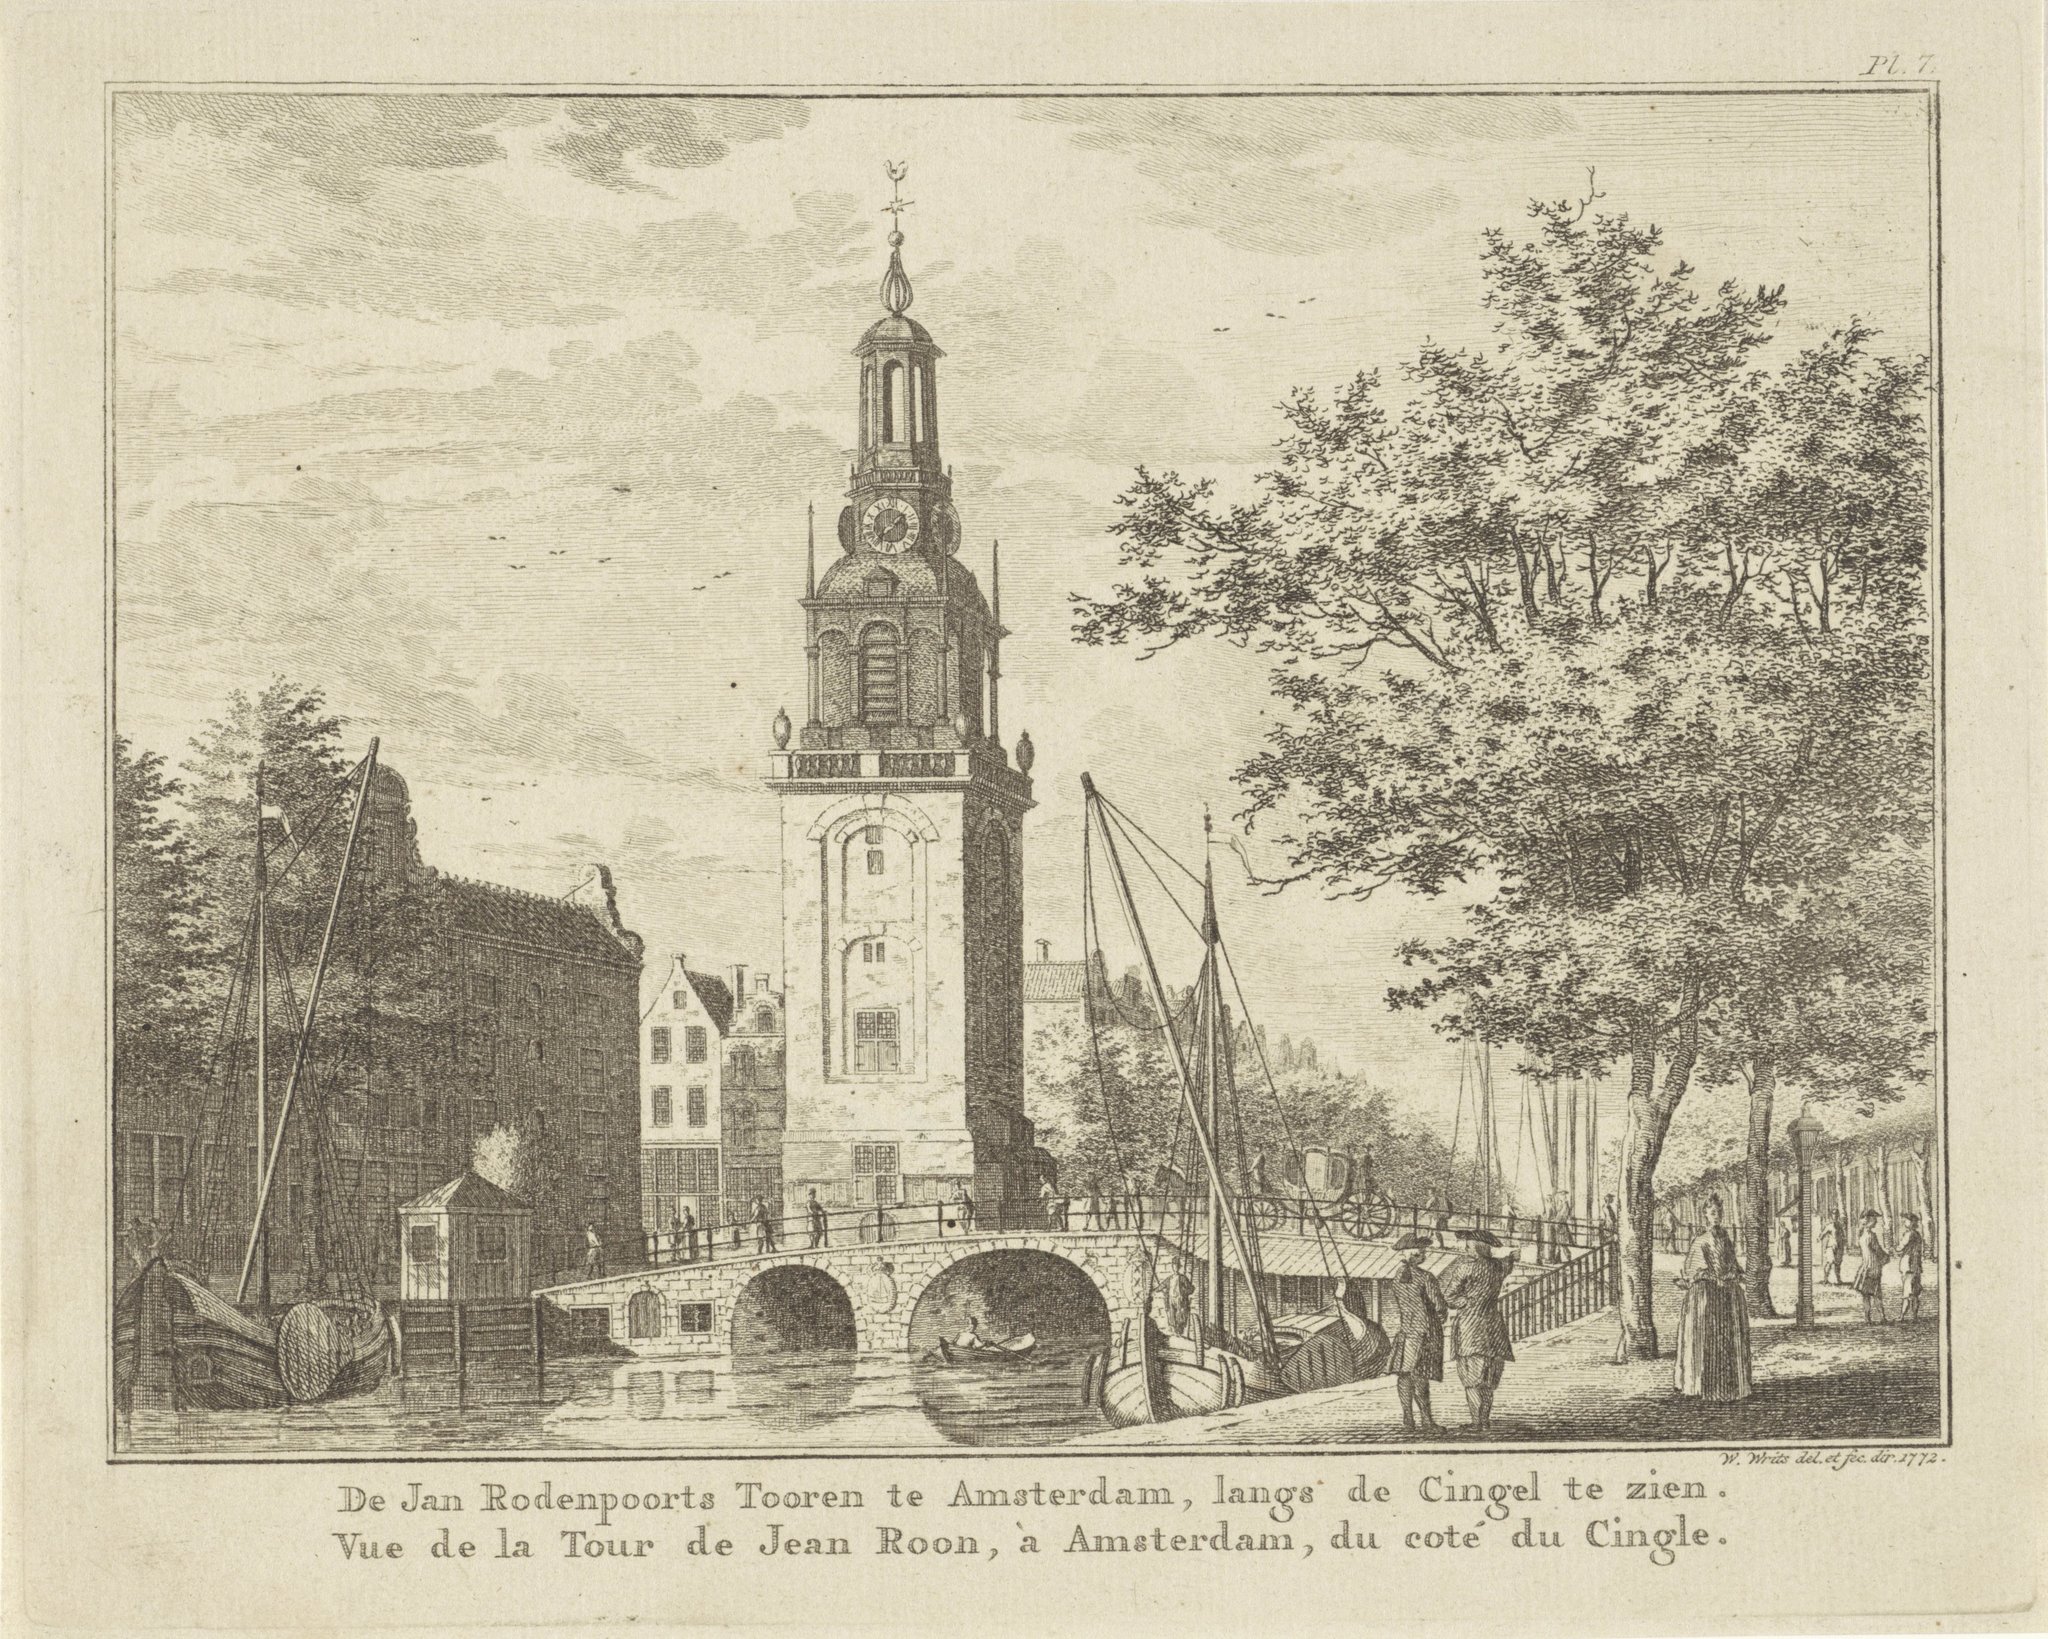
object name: print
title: Gezicht op de Jan Roodenpoortstoren te Amsterdam vanaf het Singel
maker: willem writs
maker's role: draughtsman, print maker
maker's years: 1731-1786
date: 1772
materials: paper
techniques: etching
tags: rowing-boat, canoe, etc.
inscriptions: collector's mark: Lugt 2228